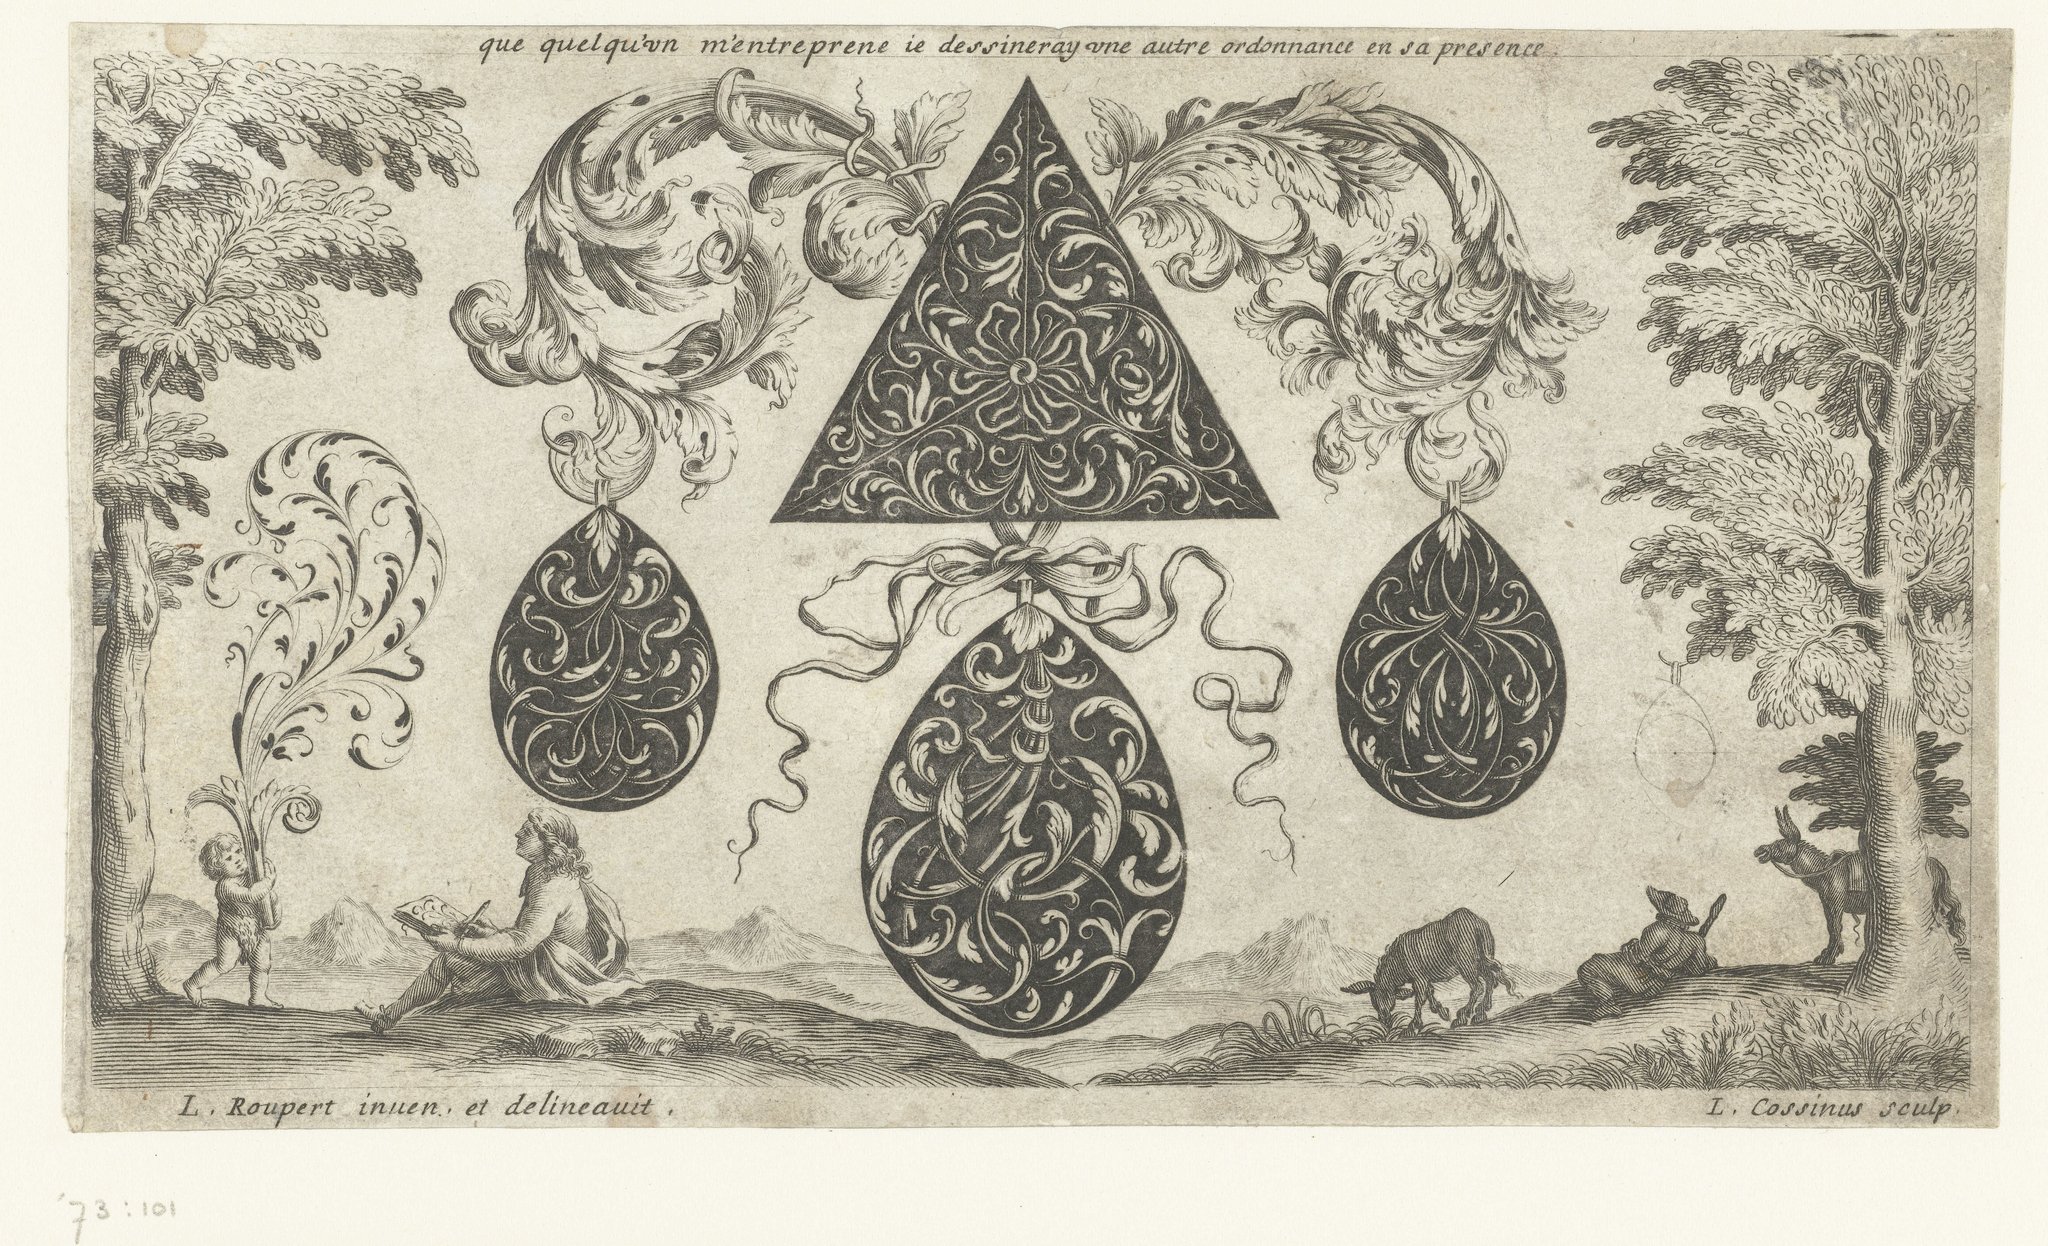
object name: print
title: Ornamenten voor edelsmeden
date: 1668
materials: paper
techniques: engraving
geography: paris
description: Drie hangers en een driehoek, bovenaan een regel tekst. Uit serie van 7 bladen, eerste editie.